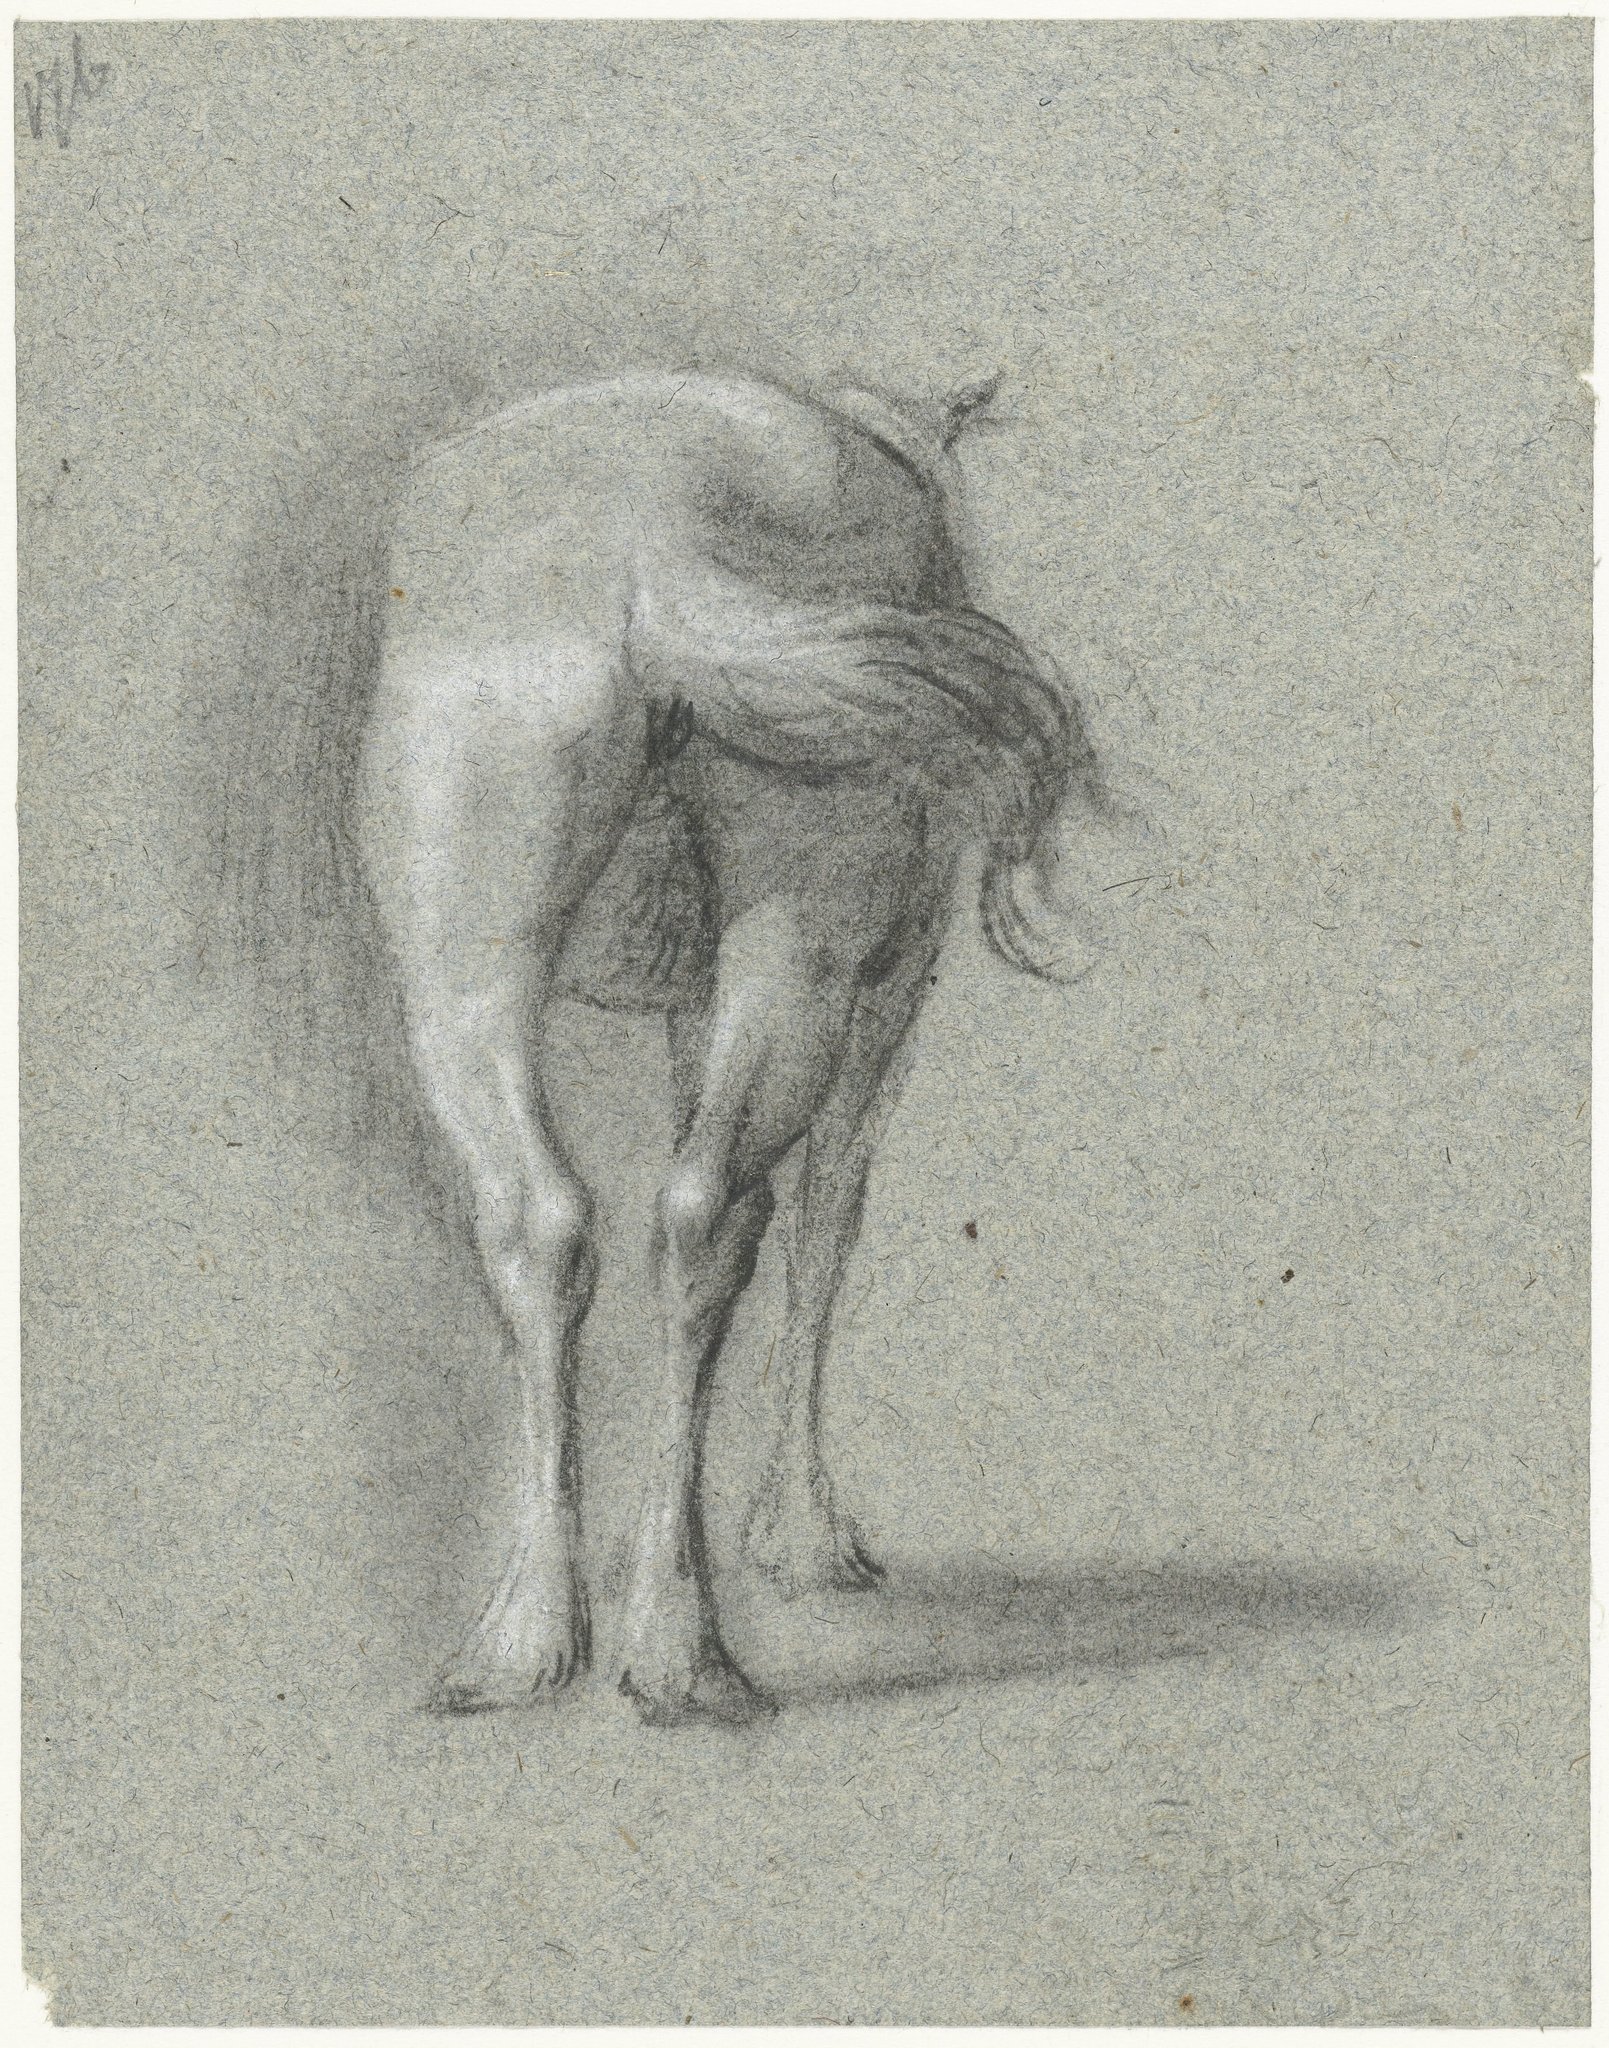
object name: drawing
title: Staande werkpaarden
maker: moses ter borch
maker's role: draughtsman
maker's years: 1645-1667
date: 1660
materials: chalk, paper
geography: zwolle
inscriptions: annotation: ‘7’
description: Blad uit serie van 8 tekeningen van werkpaarden, waarschijnlijk naar het leven getekend.